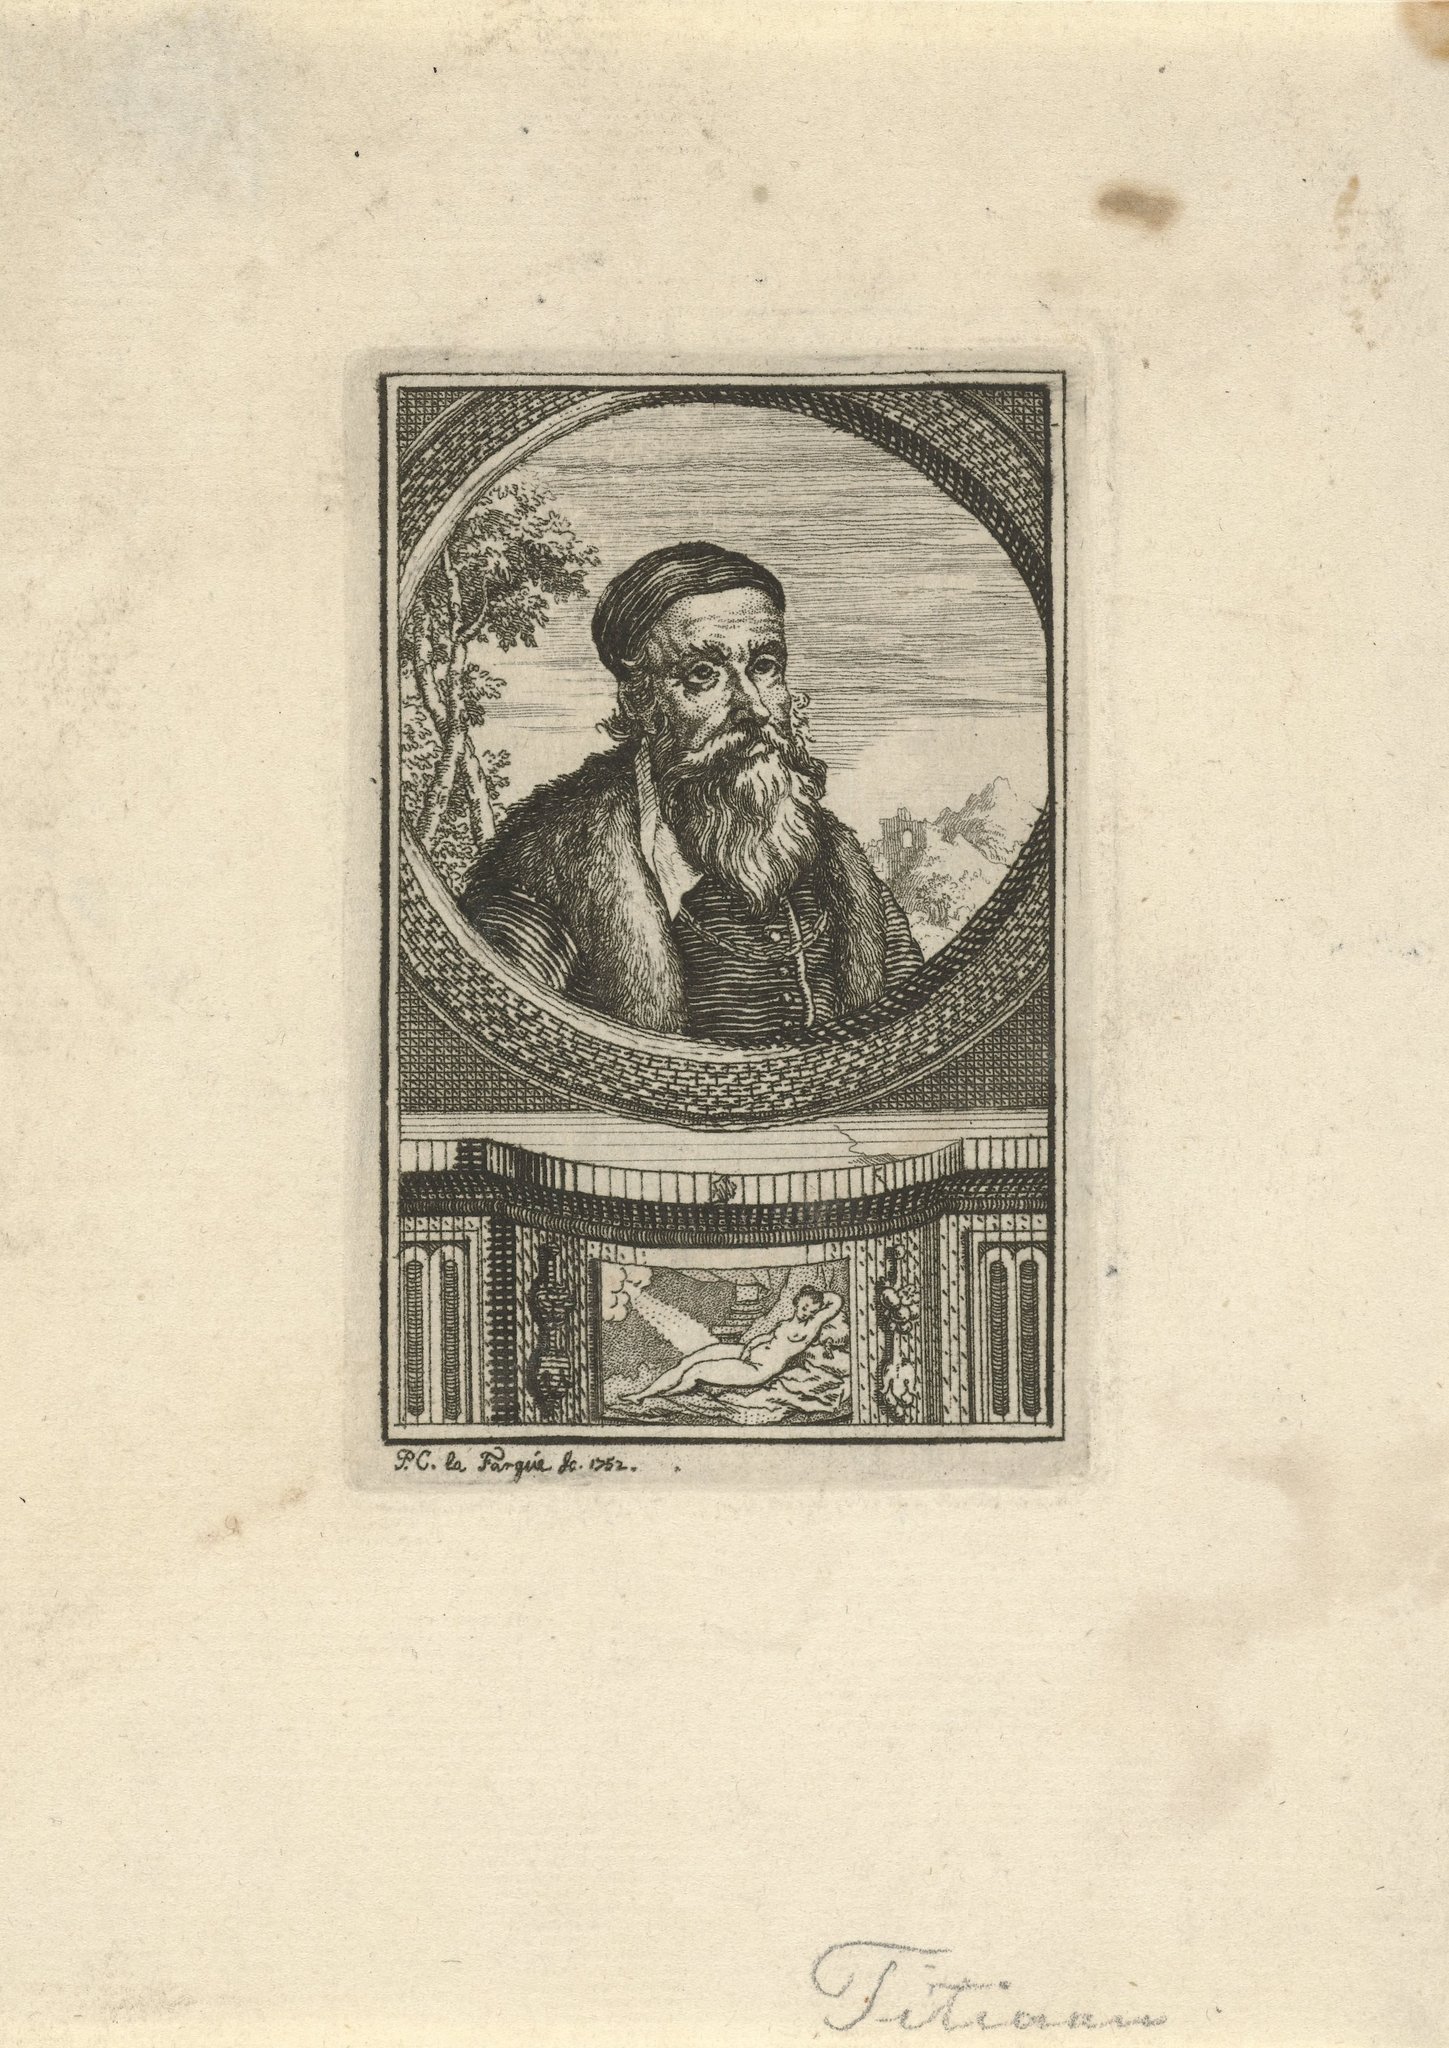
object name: print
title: Portretten van Italiaanse kunstenaars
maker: isaac lodewijk la fargue van nieuwland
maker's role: draughtsman, painter, print maker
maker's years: 1726-1805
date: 1752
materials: paper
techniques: etching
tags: venice, draughtsman, titiaan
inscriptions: collector's mark: Lugt 2228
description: Prent opgenomen in: Dézallier d'Argenville, Antoine Joseph. Tooneel der uitmuntende schilders van Europa, en byzonderlyk van Nederland. Den Haag: Mattheus Gaillard, 1752.